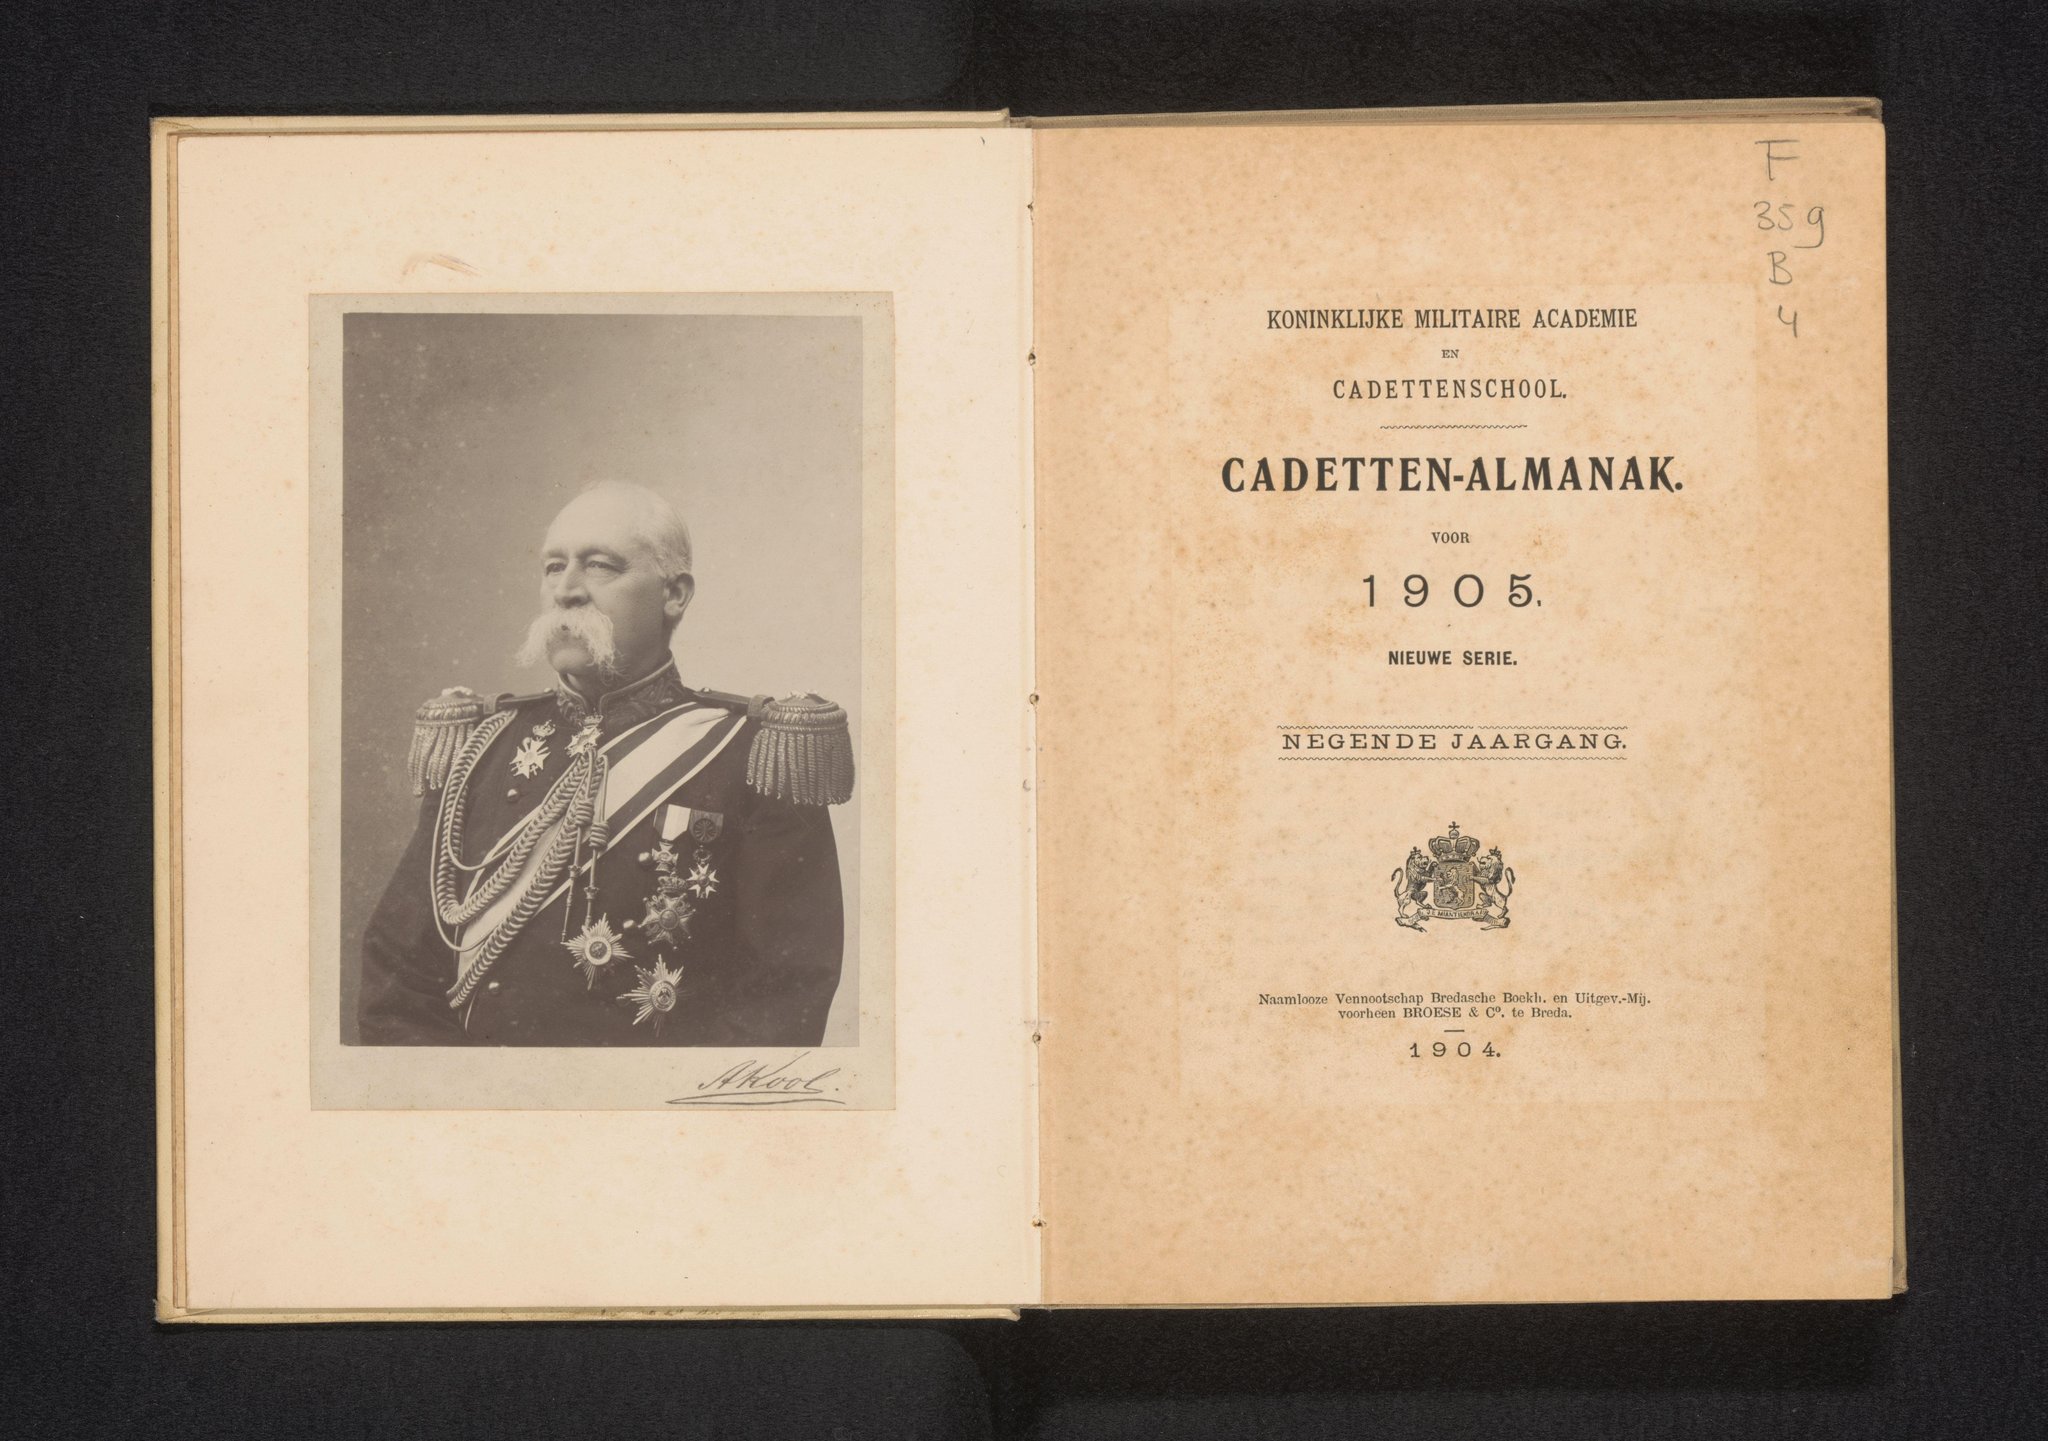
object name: page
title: Portret van officier Arthur Kool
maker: Anonymous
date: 1899-1904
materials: photographic support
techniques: gelatin silver print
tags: the hague, historical persons